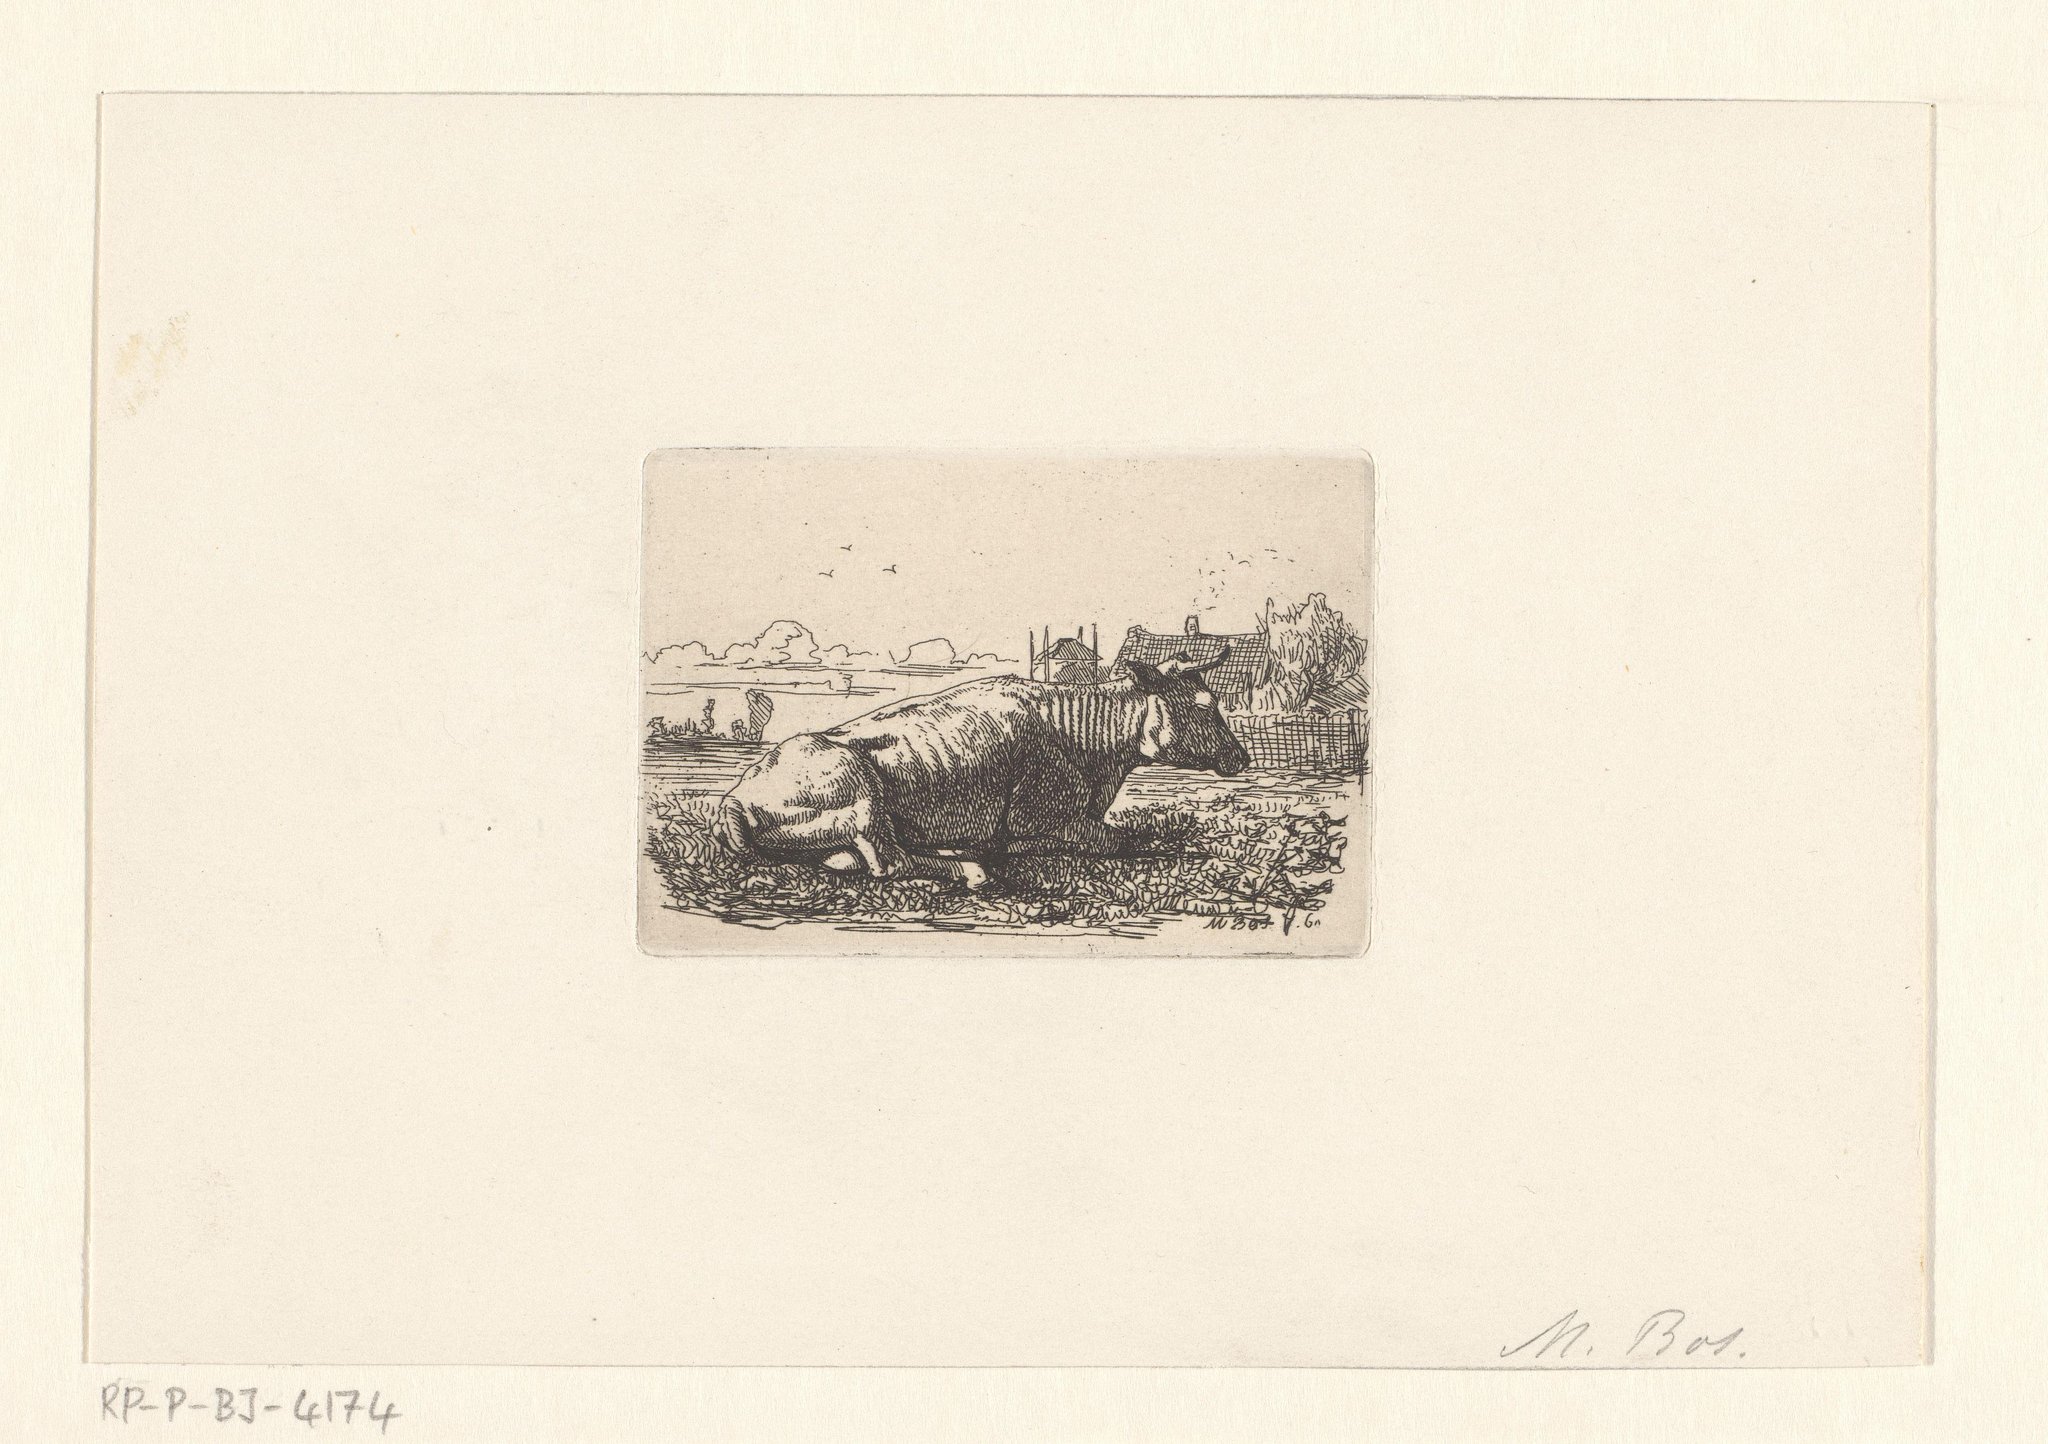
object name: print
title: Liggende koe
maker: maarten bos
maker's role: painter, print maker, printer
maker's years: 1831-1902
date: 1861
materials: paper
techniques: etching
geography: netherlands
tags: cow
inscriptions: collector's mark: Lugt 2228